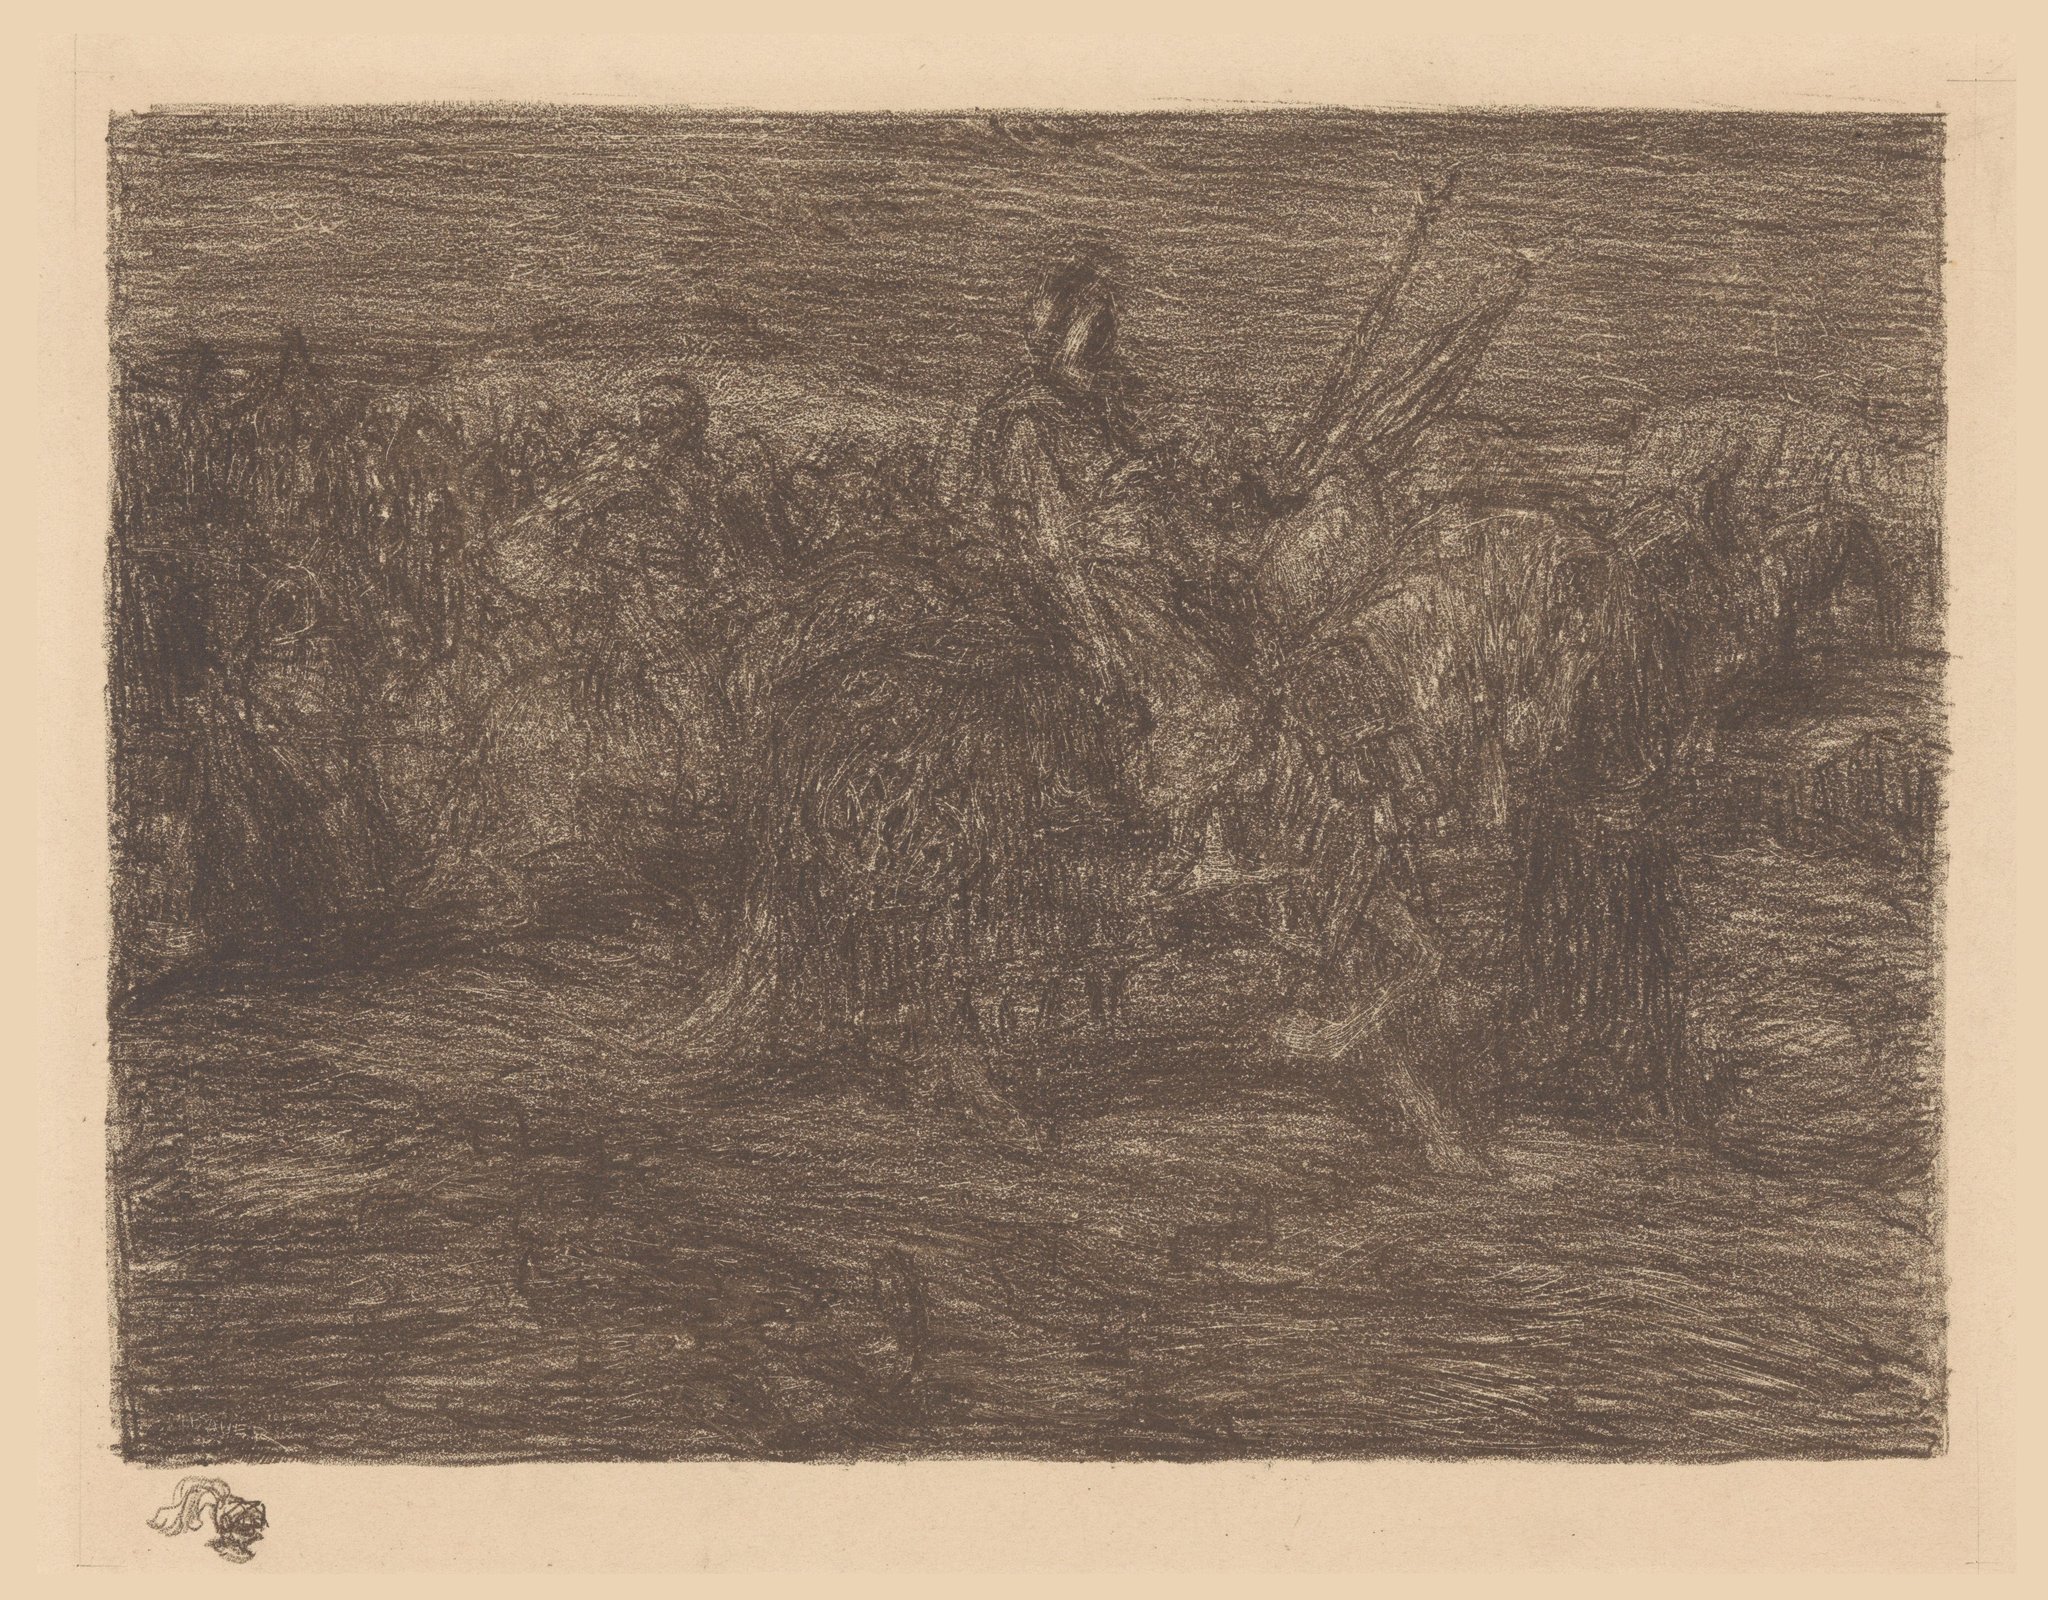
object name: print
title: Ruiters in de duisternis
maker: marius bauer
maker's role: draughtsman, print maker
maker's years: 1867-1932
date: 1877-1931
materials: paper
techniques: lithograph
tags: riding a horse, ass, or mule; rider, horseman, darkness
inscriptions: collector's mark: Lugt 2228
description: Een groep ruiters te paard in de duisternis. Op de achtergrond heuvels. Onder de prent het hoofd van een ruiter die een helm met pluim draagt.